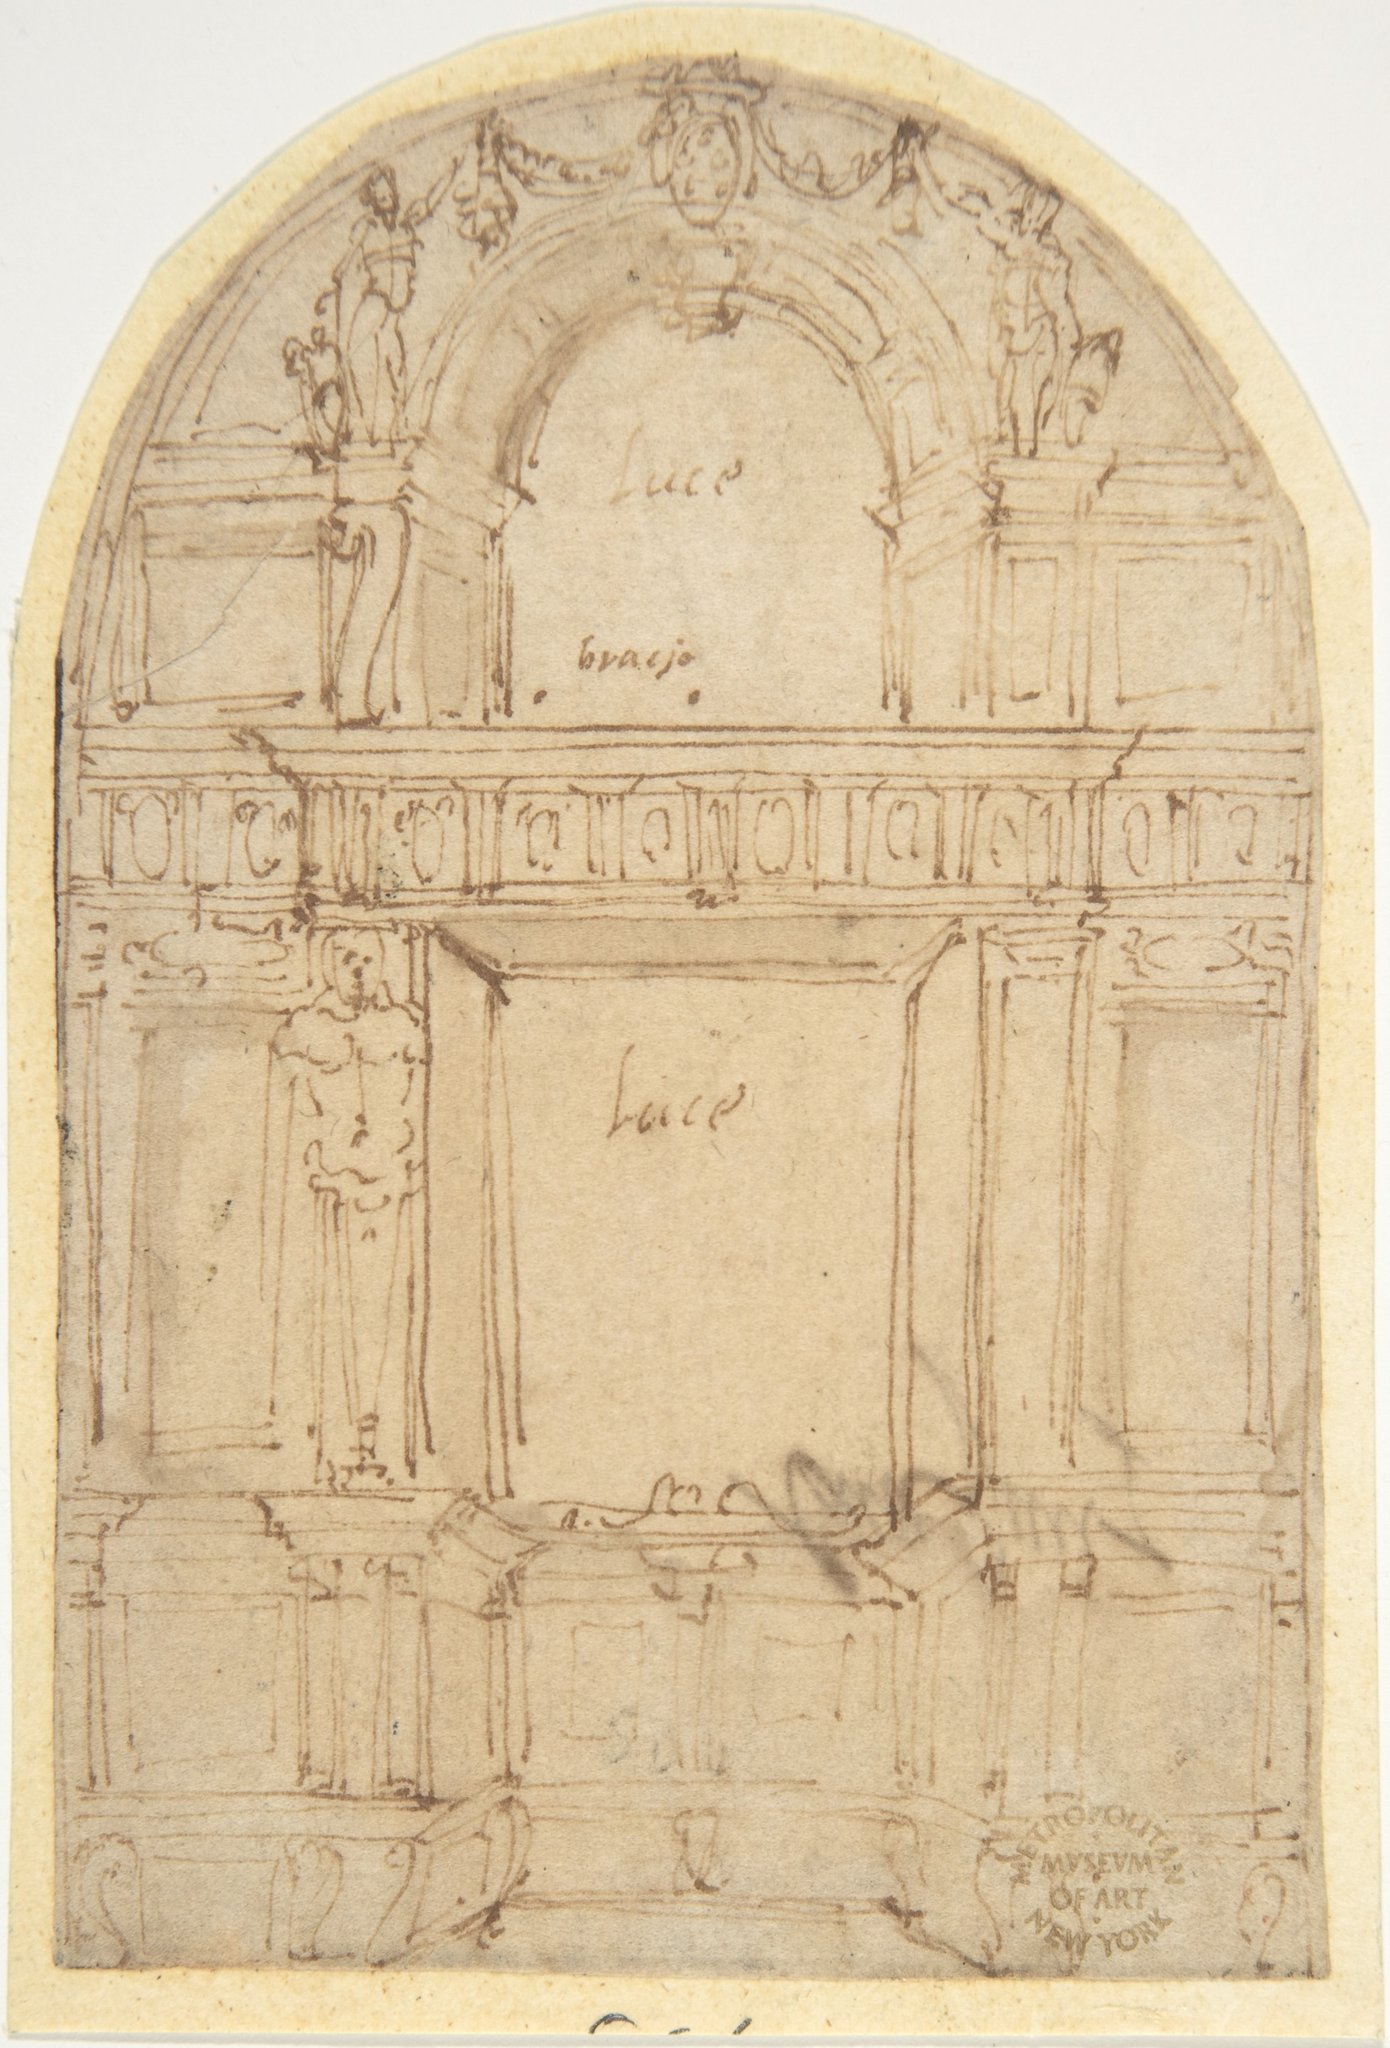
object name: collection ornament architecture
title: Design for a Wall with Two Windows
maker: anonymous, italian, 16th century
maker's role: artist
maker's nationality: italian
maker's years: 1550-1600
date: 1501-1600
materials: ink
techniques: pen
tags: windows,caryatids